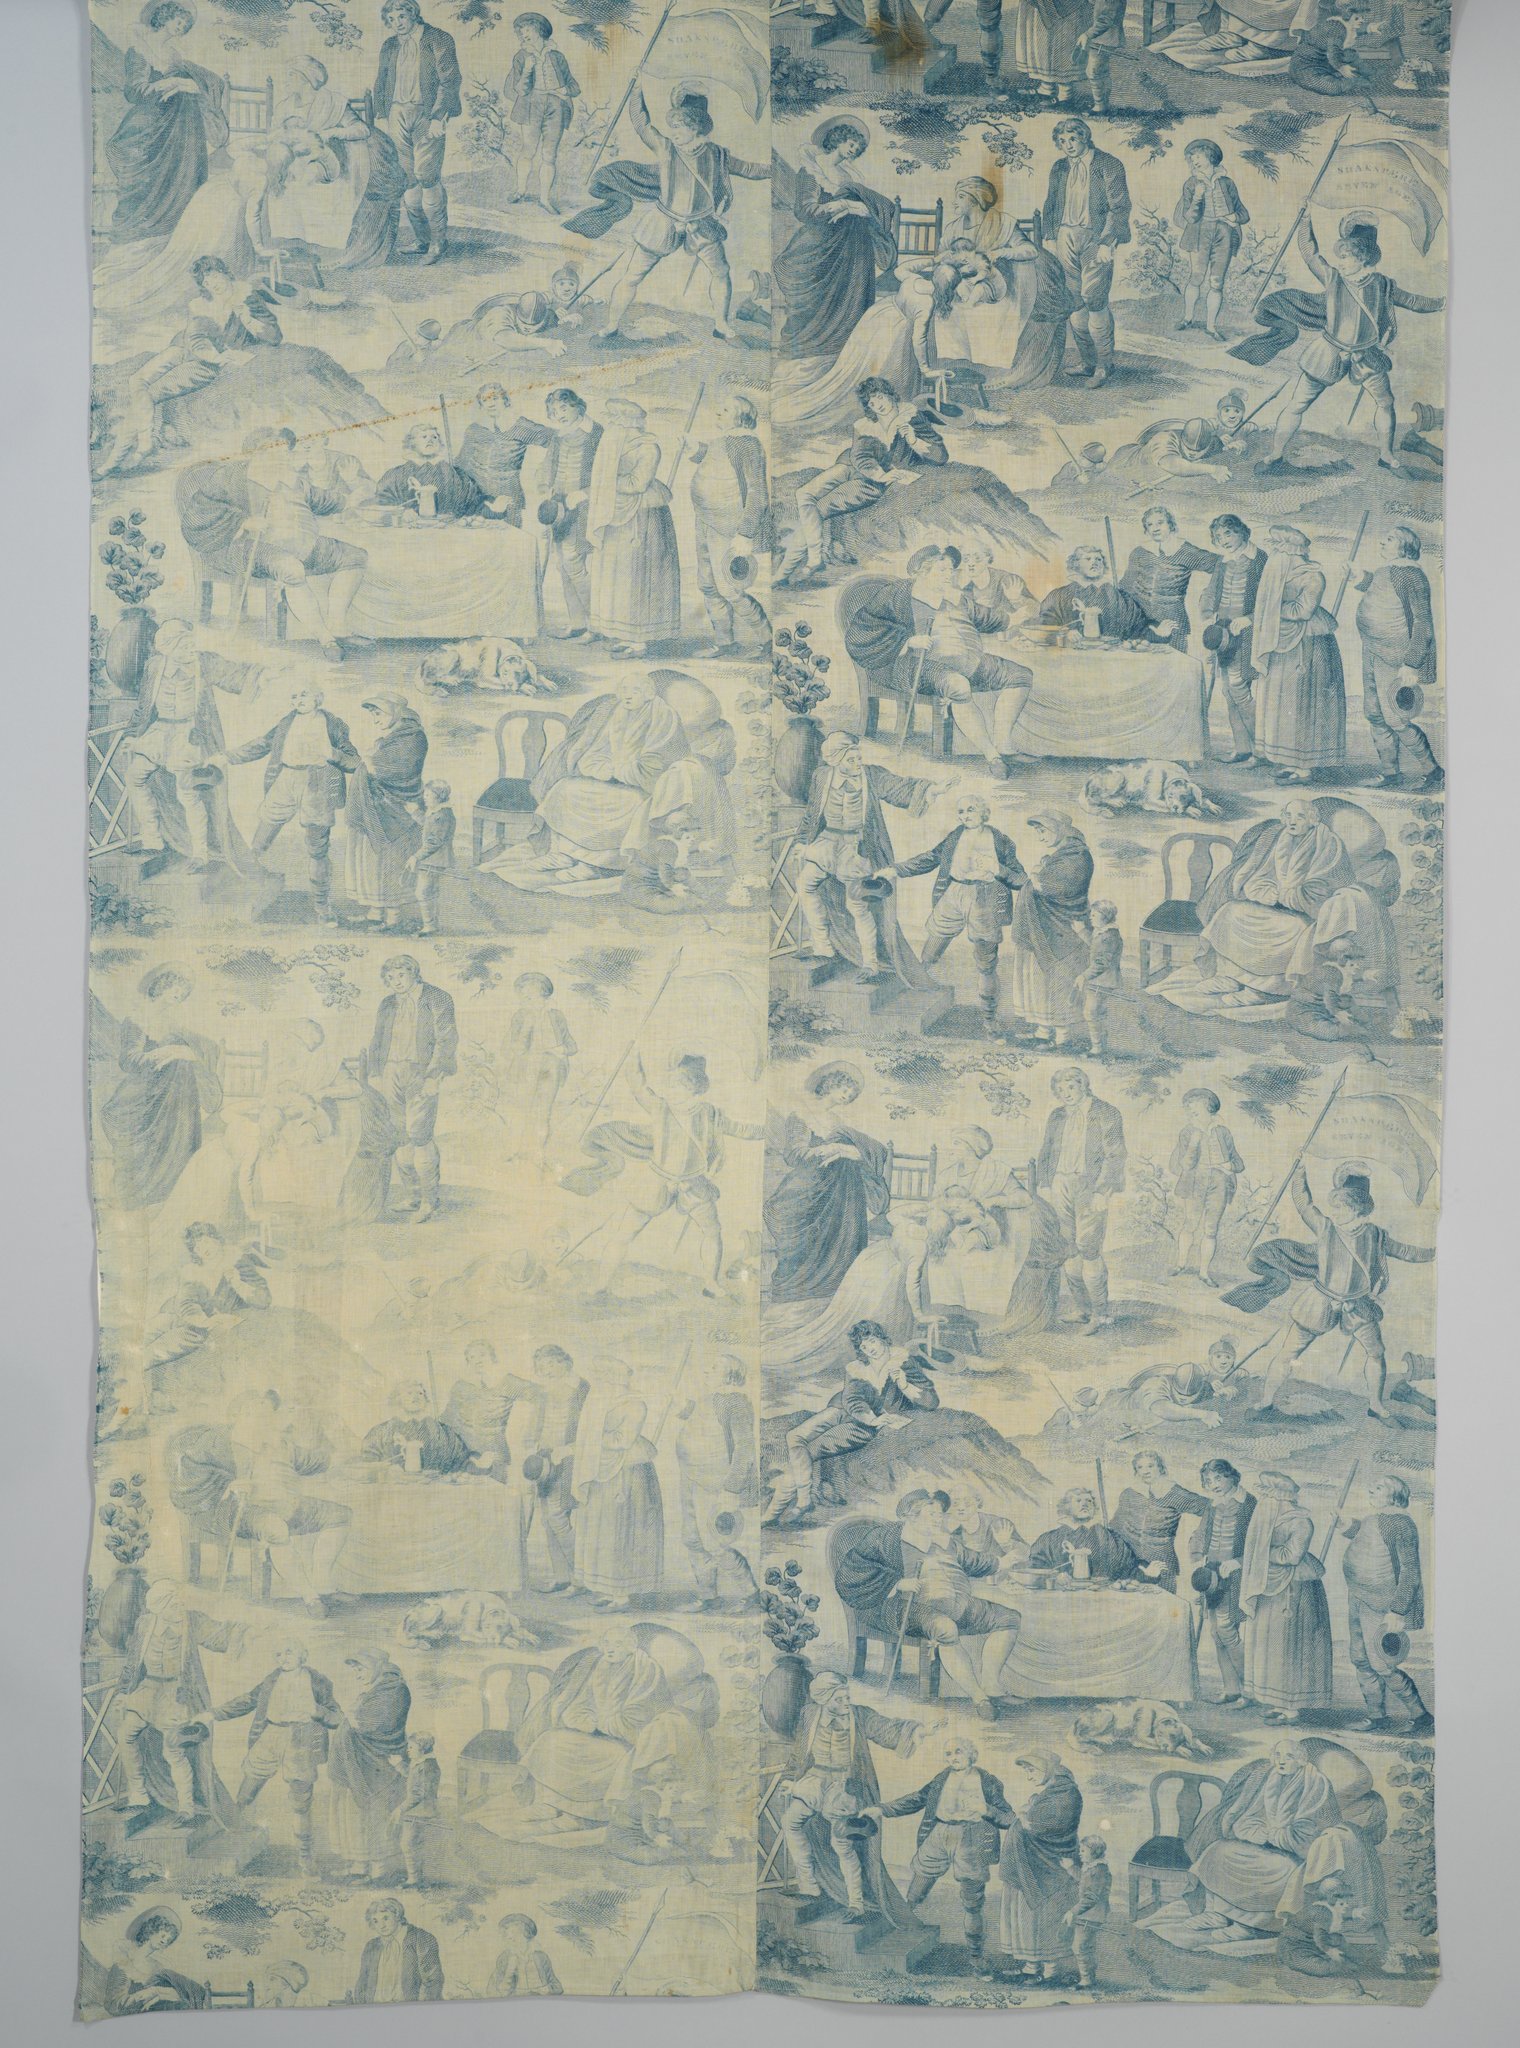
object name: piece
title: Shakespeare's "Seven Ages of Man"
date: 1805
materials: cotton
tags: boys,men,women,dogs,tables